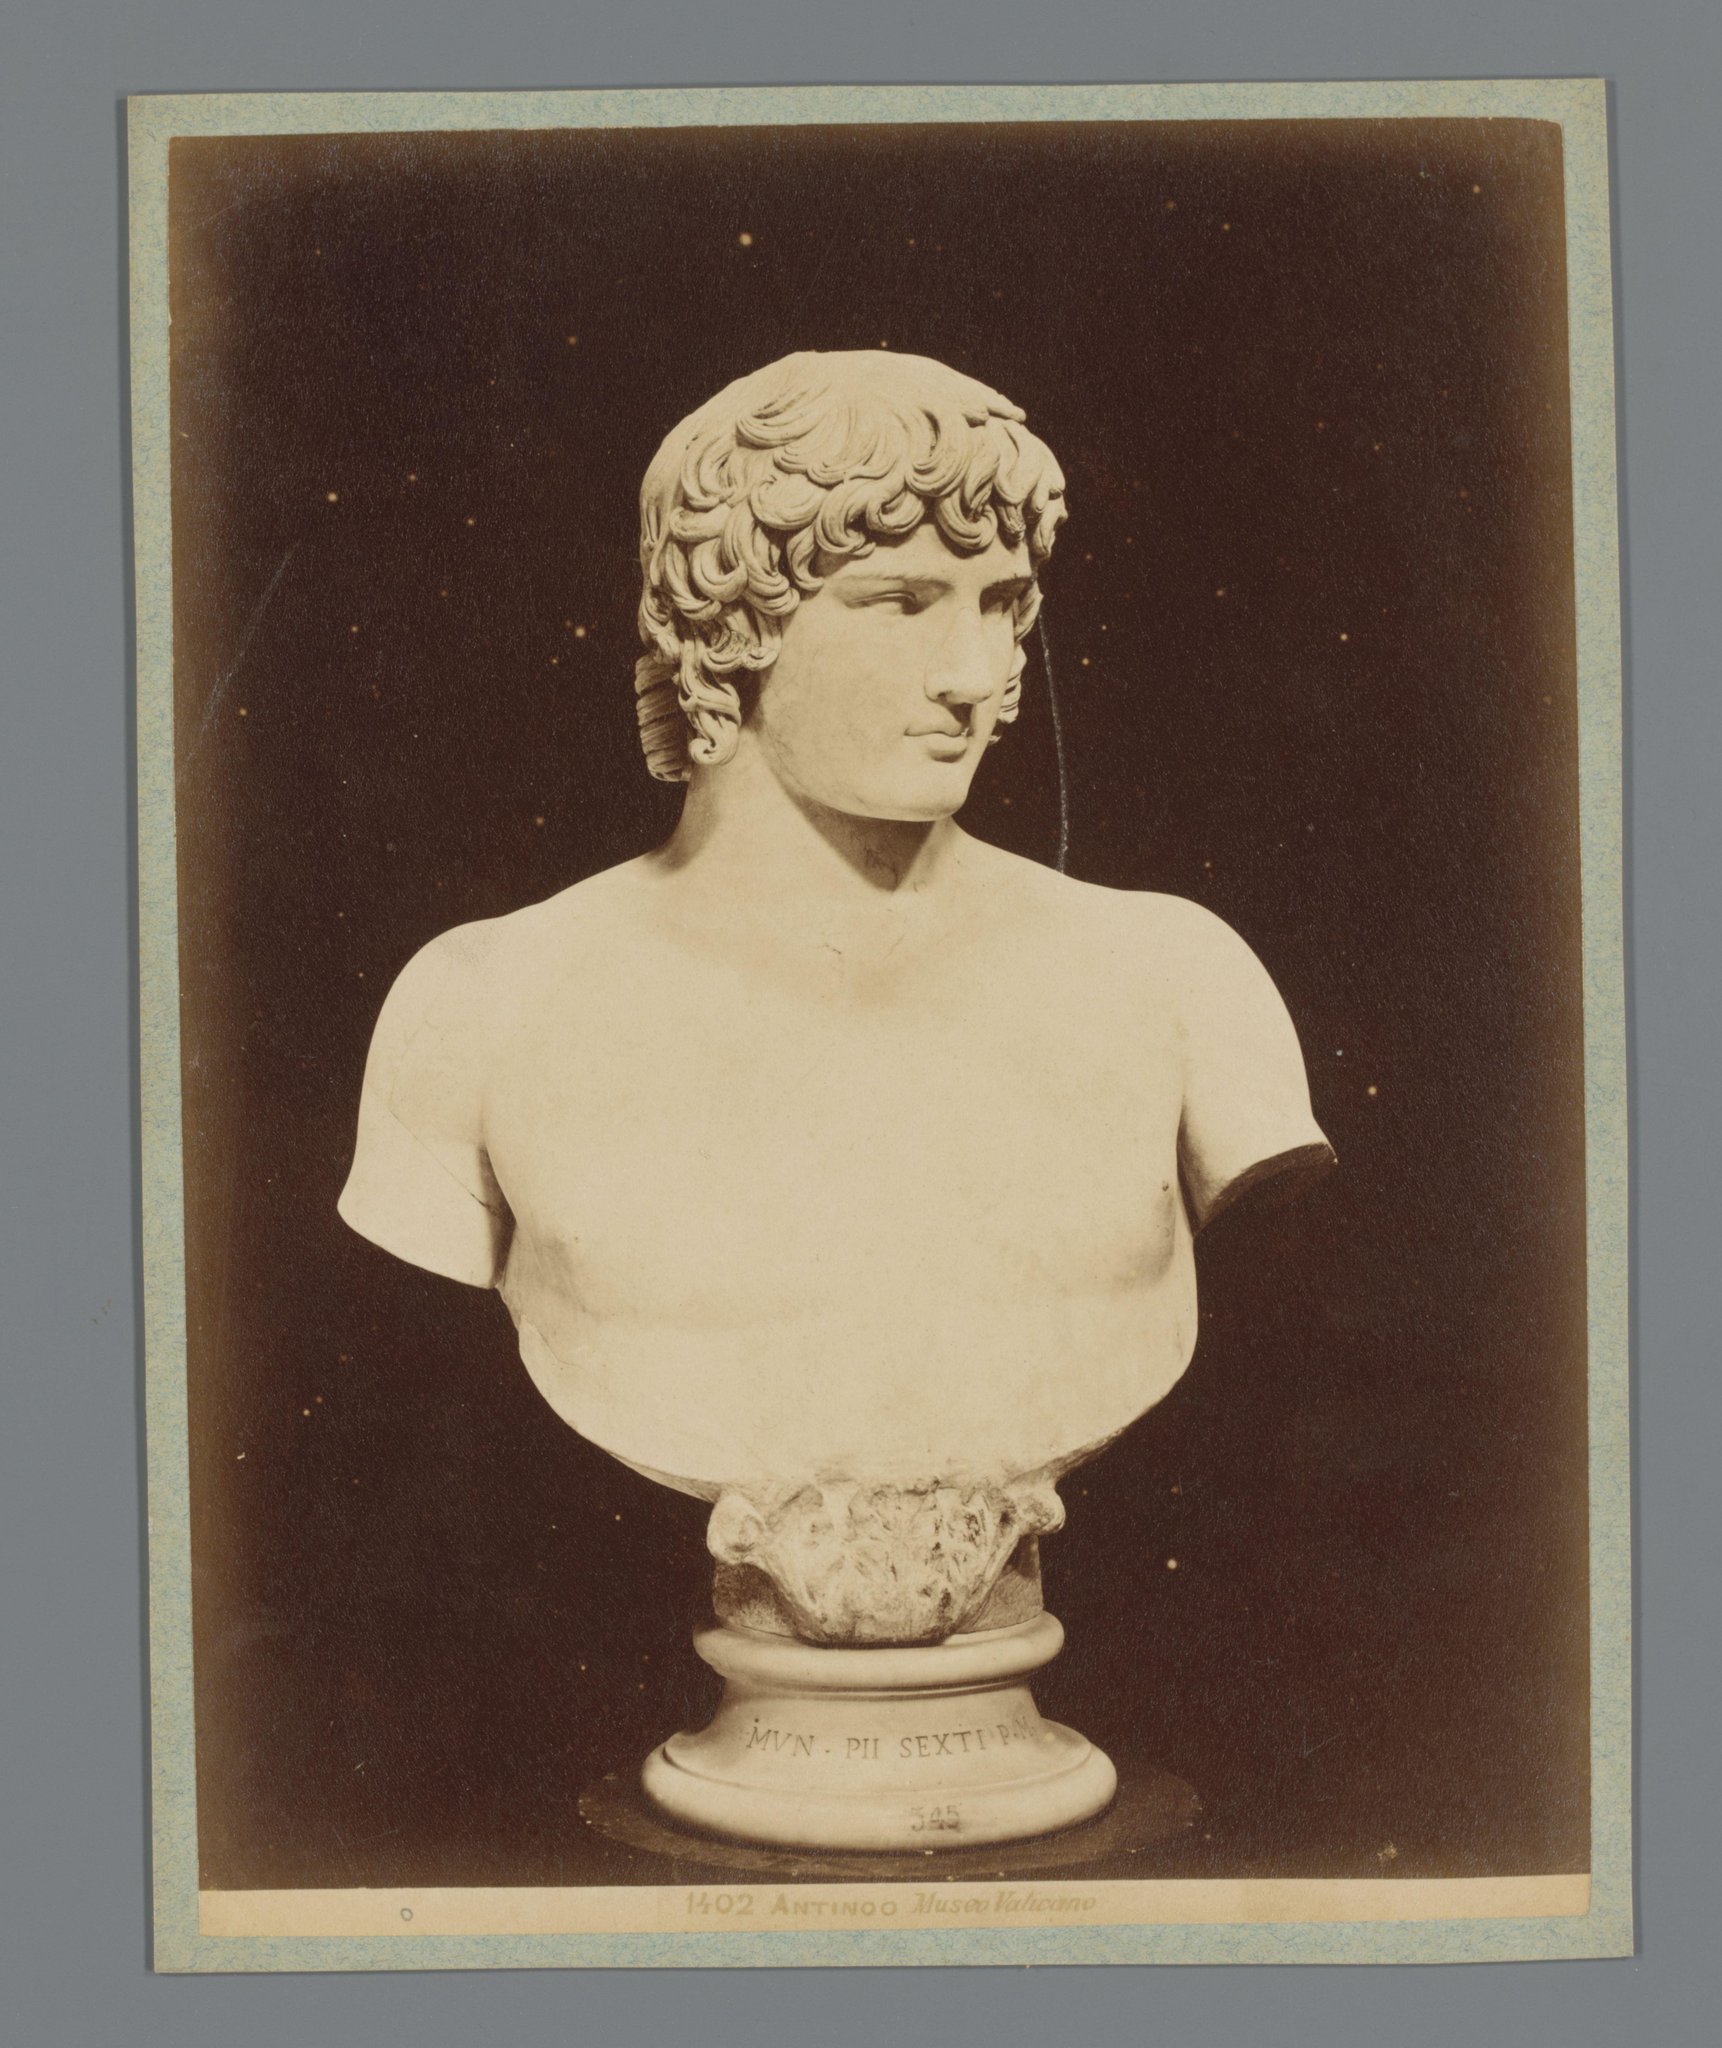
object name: photograph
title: Buste van Antinoüs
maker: Anonymous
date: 1851-1900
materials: cardboard, paper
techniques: albumen print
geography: vatican city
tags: monument, statue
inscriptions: collector's mark: ‘VOSMAER’, number: ‘1402’